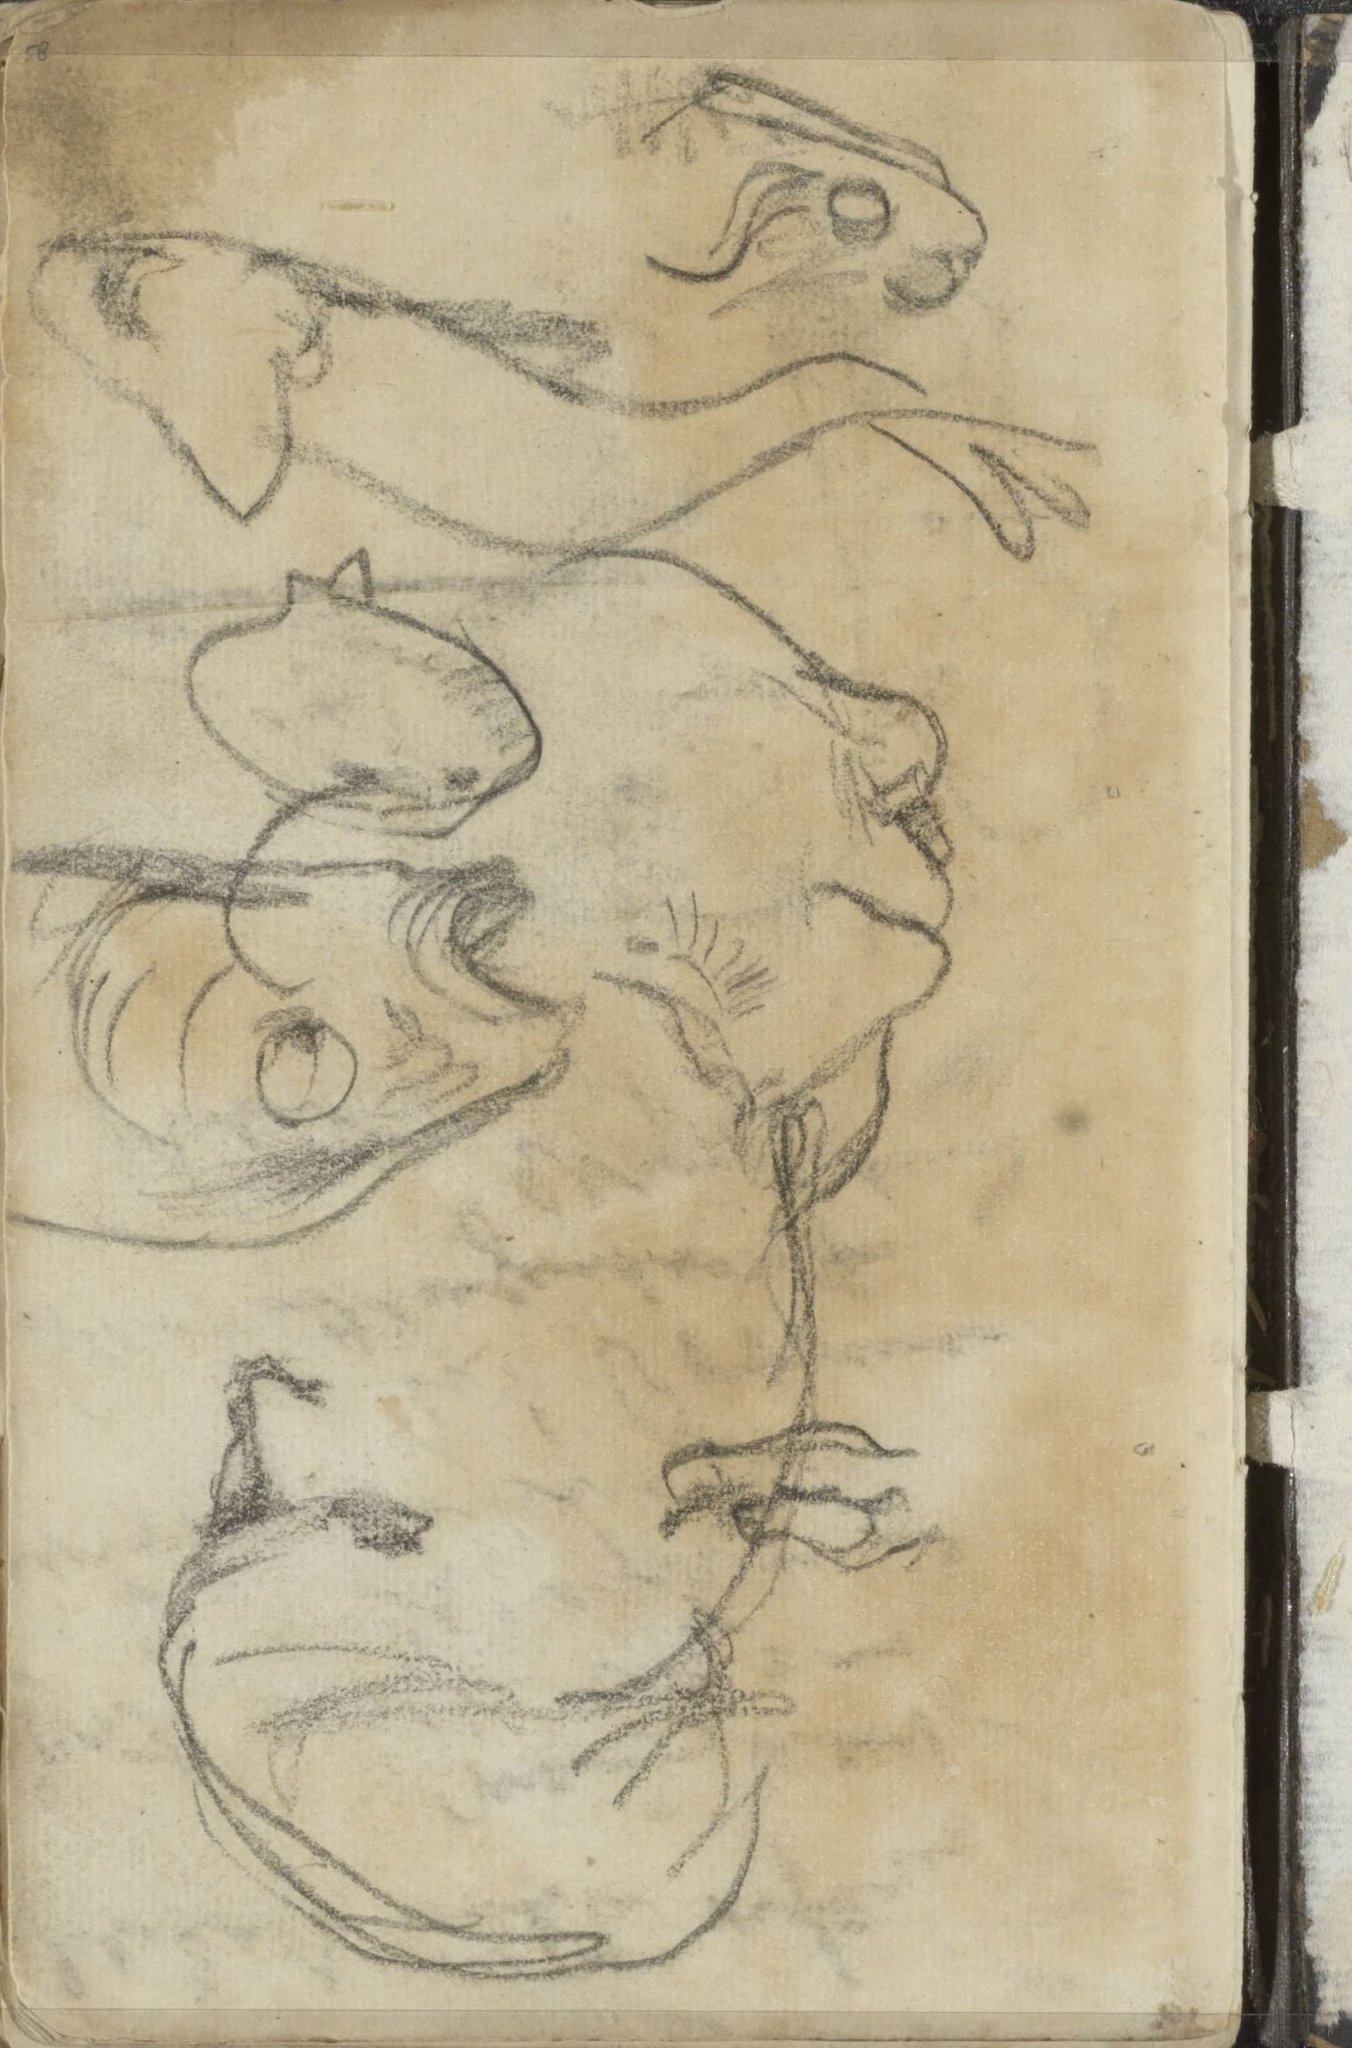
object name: sketchbook leaf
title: Studieblad met hoofden, vissen en kikkers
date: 1881-1883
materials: chalk, paper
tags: tailless amphibians: frog, head (human), fishes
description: Pagina 58 uit een schetsboek met 29 bladen.